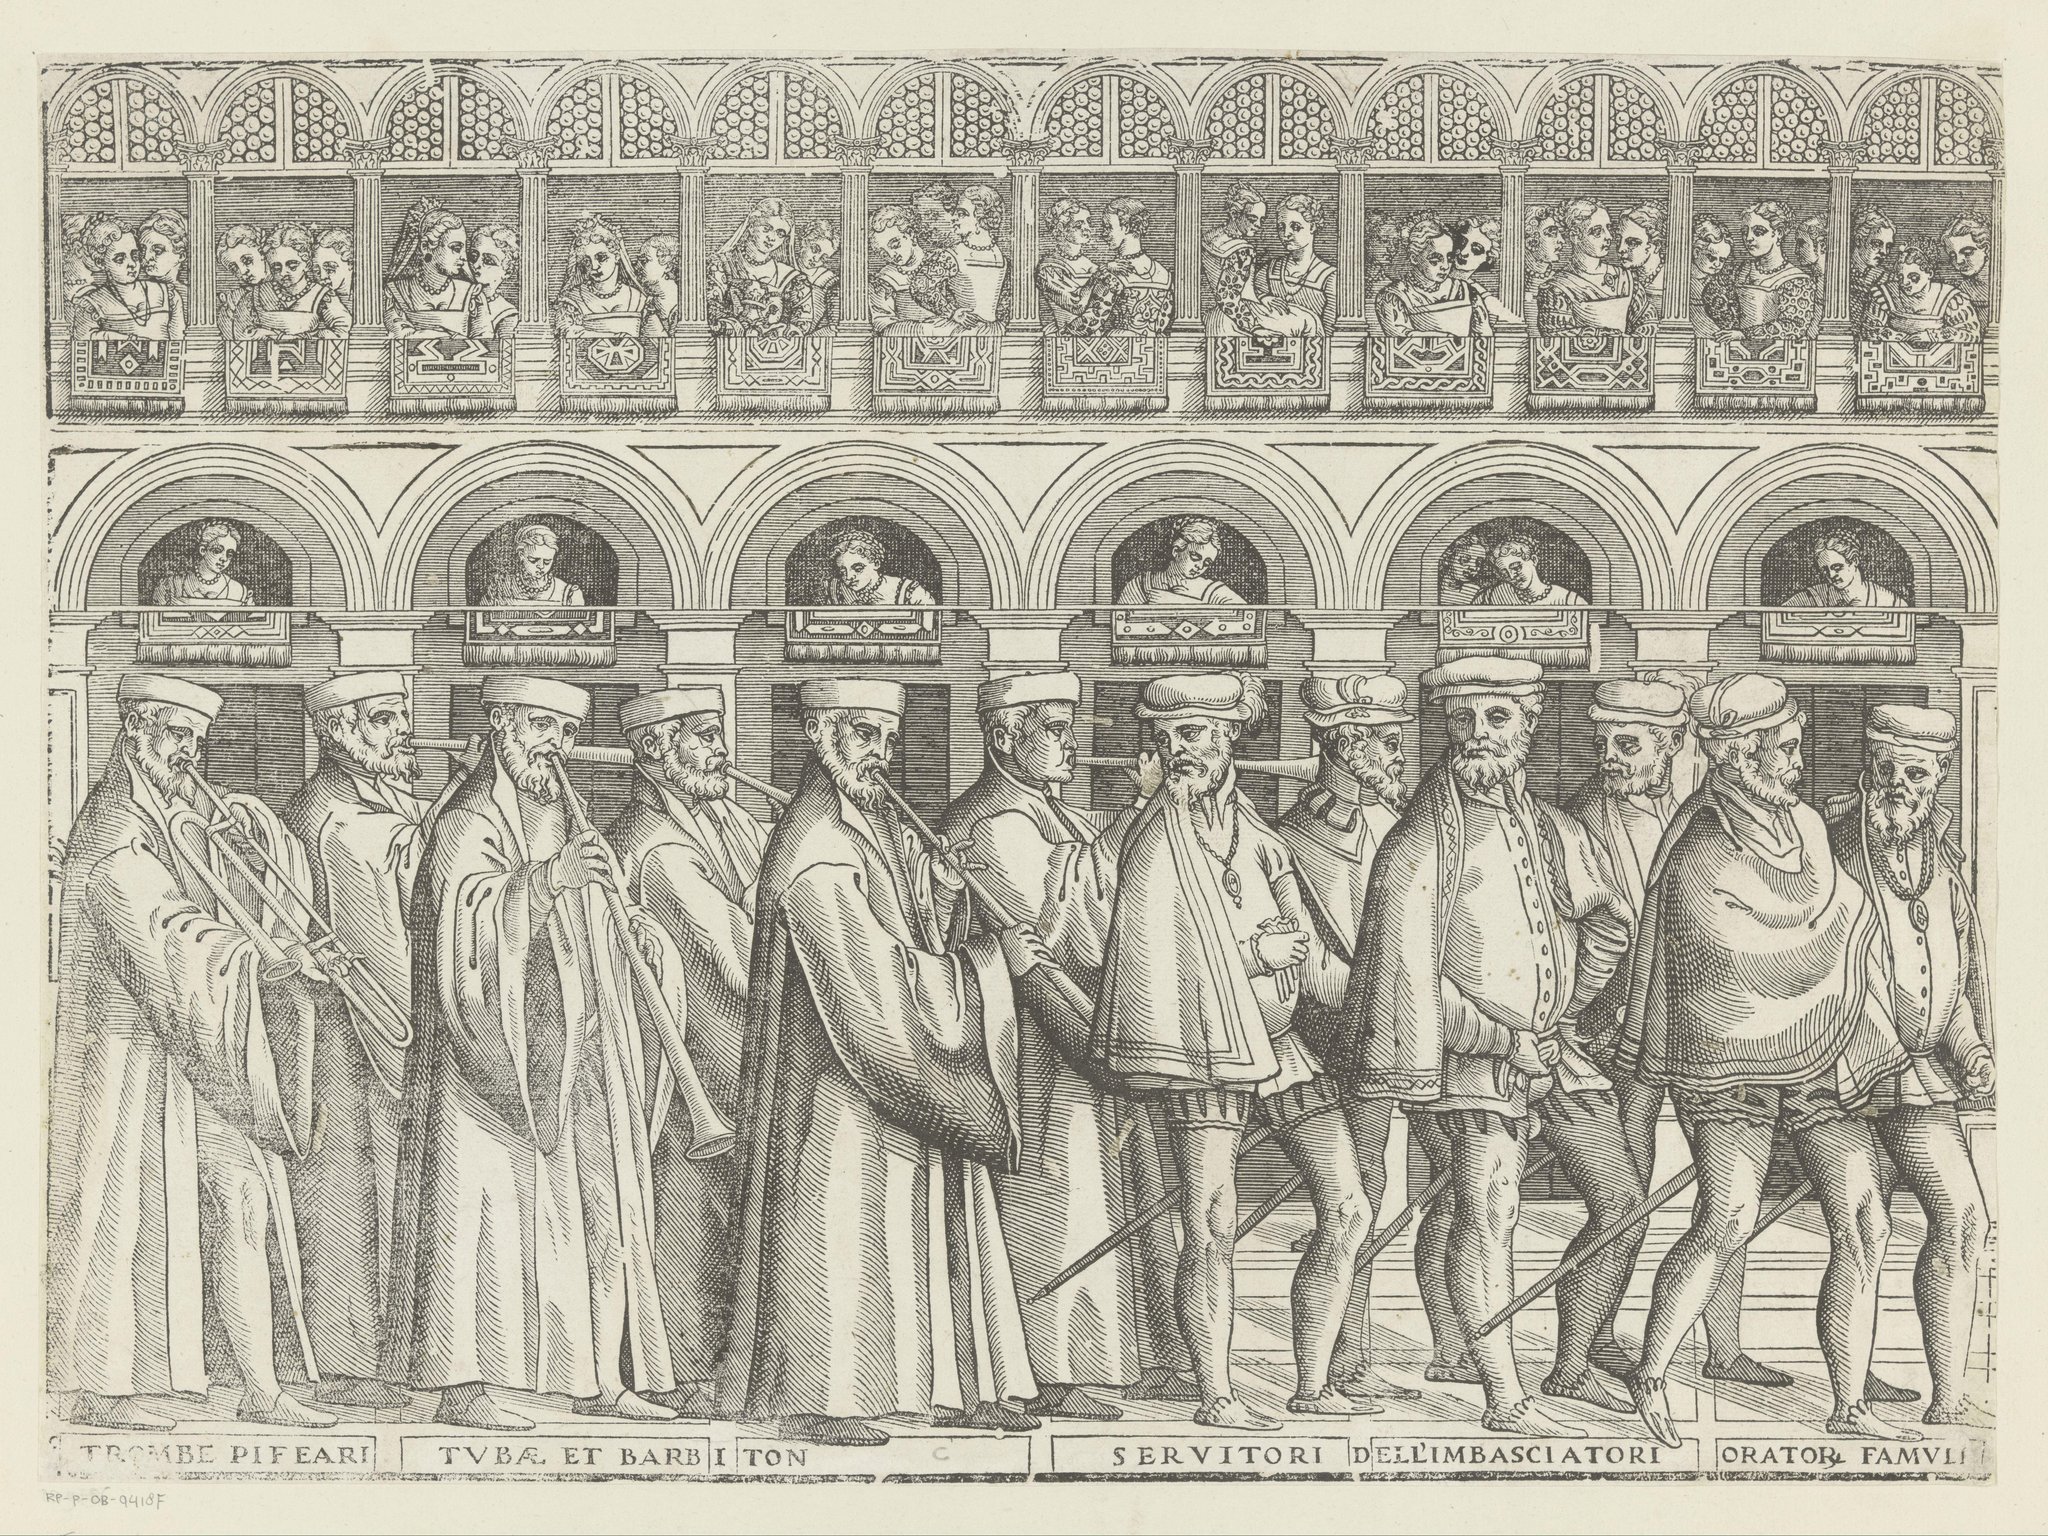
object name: print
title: Procession of the Doge of Venice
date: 1555-1560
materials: paper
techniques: woodcut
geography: italy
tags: horn, trumpet, cornet, trombone, tuba, procession ~ christian religion, other sovereign: doge, venice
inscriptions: collector's mark: Lugt 2228, collector's mark: Lugt 240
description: The processions of the Doge in Venice included six long silver trumpets. These legendary musical instruments, reserved exclusively for the Doge, were bestowed upon the city by Pope Alexander III in 1177 as a reward for the bravery of Doge Ziani, who defended the papacy against German invaders. The trumpets and their sound were a traditional symbol of authority, civic pride, and triumph.